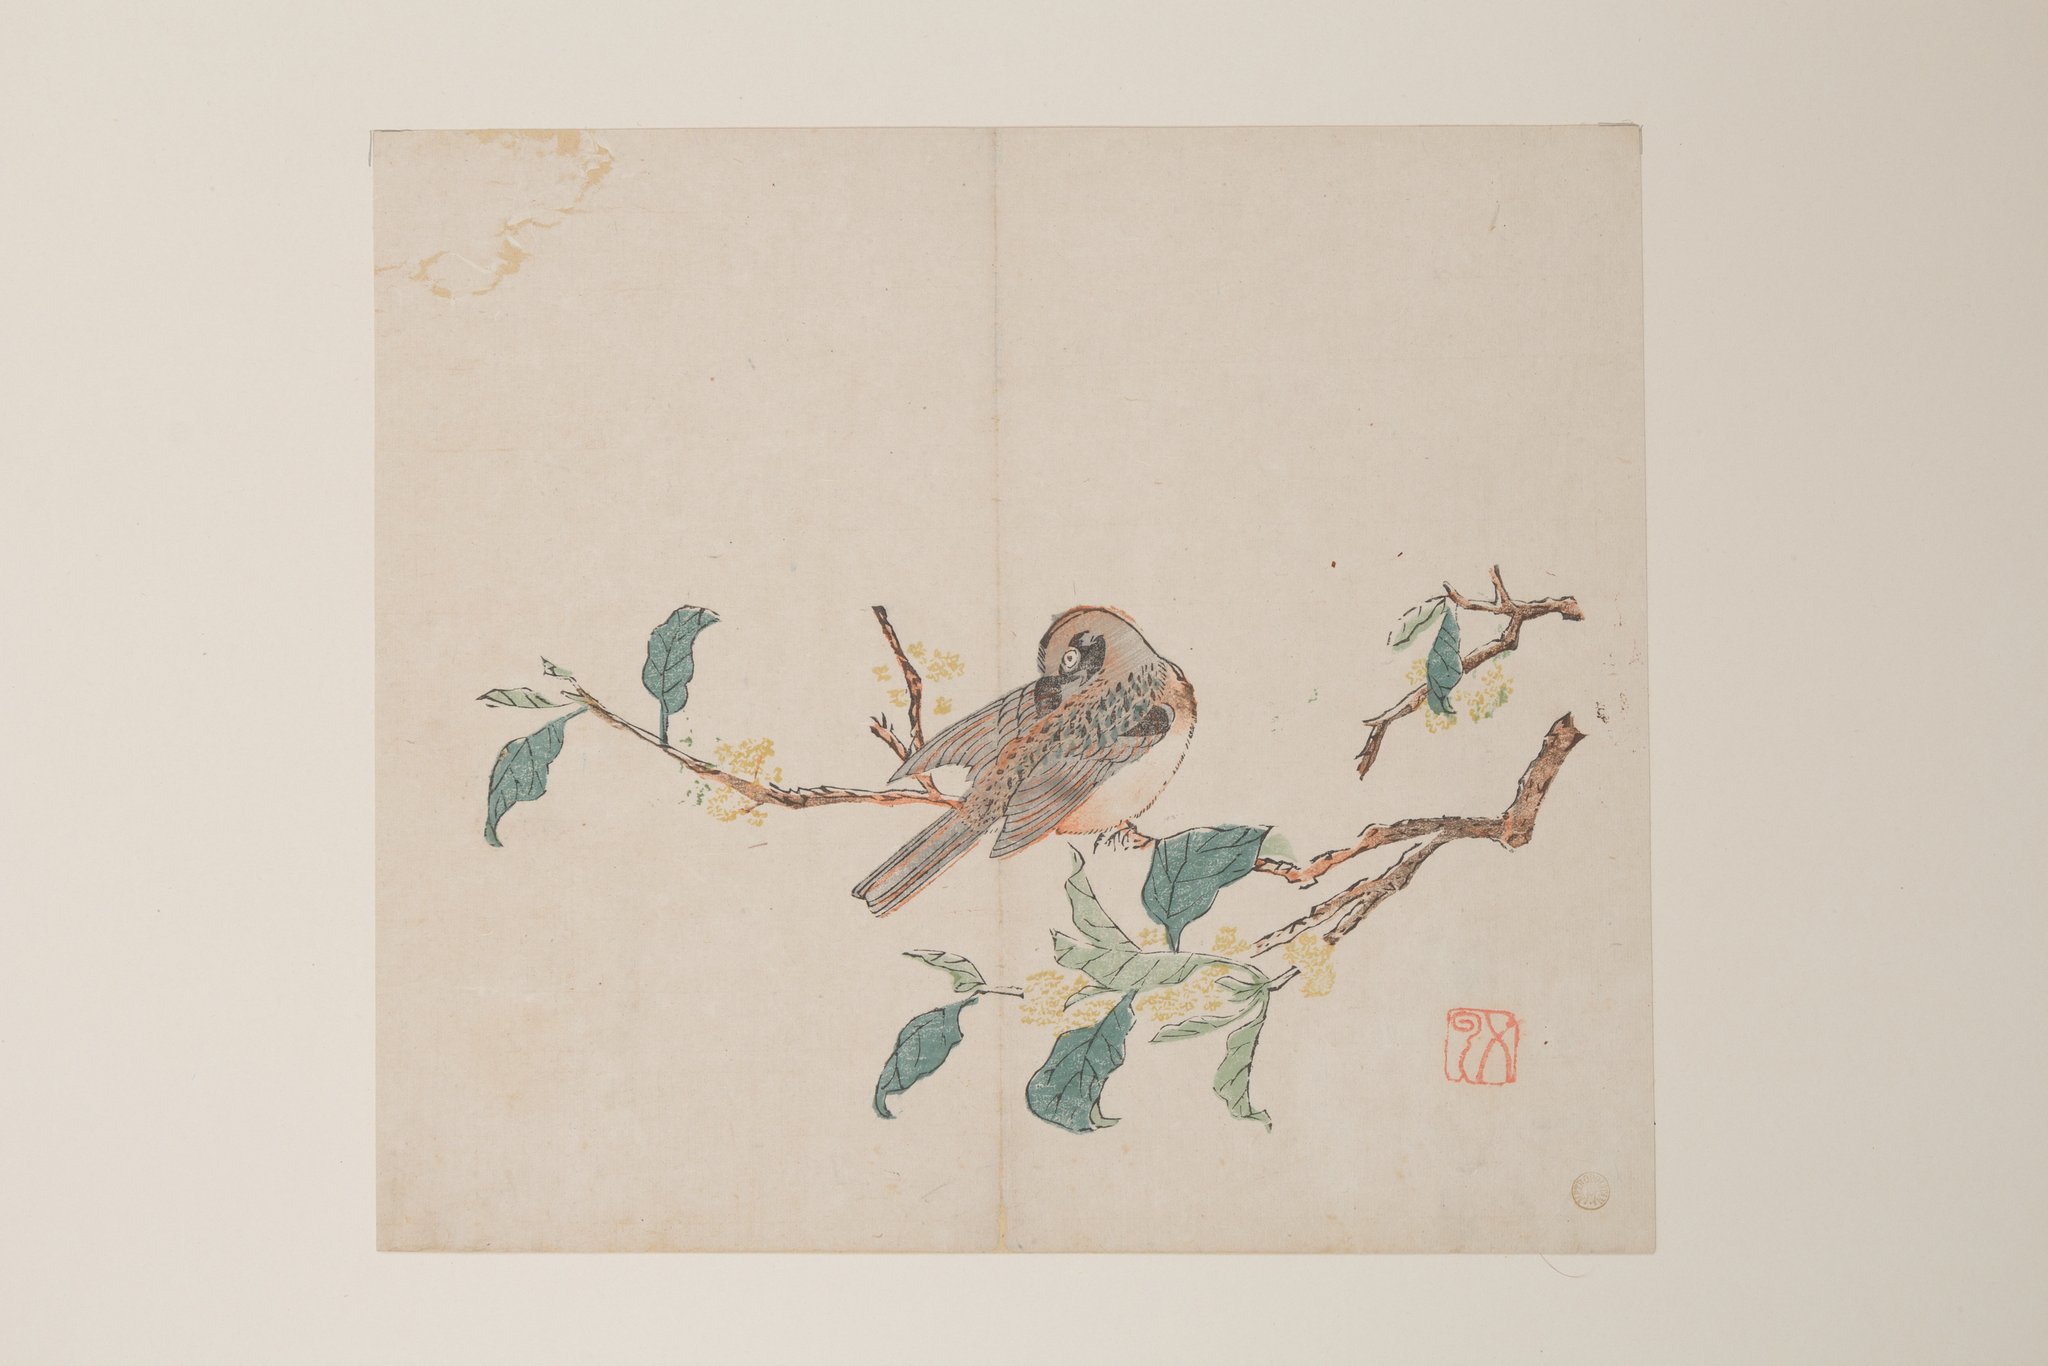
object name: print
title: Leaf from the Ten Bamboo Studio Manual of Painting and Calligraphy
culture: chinese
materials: ink, paper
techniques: printing